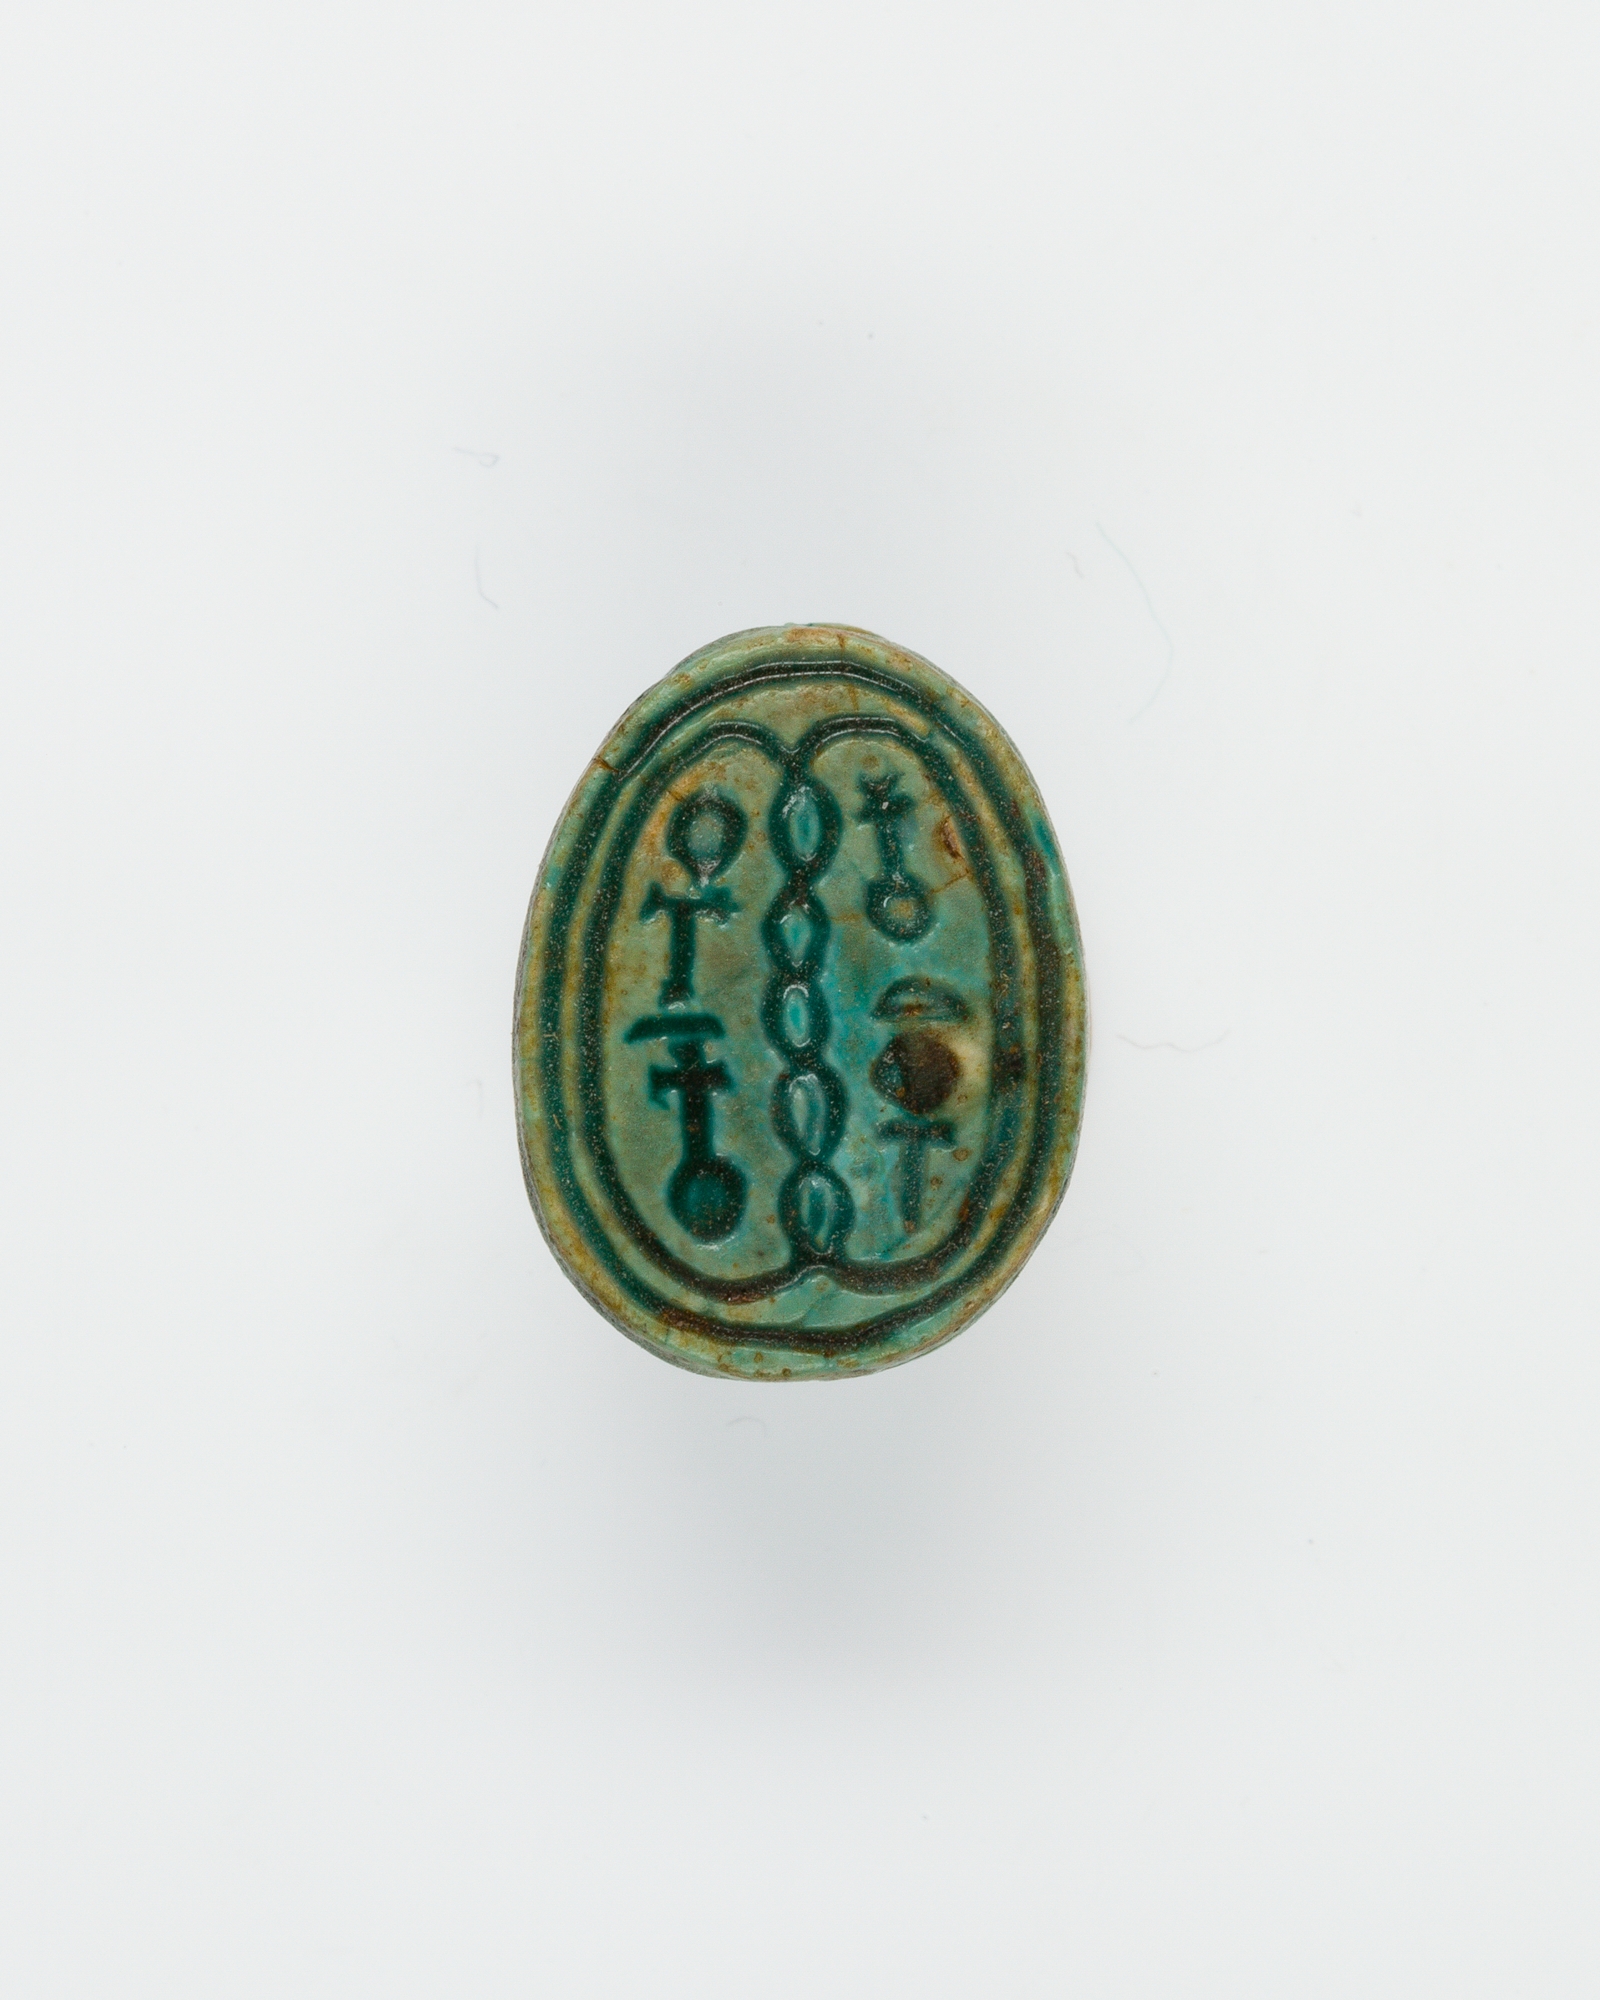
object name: scarab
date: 1492-1479 BCE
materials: stone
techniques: glazing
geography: egypt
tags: scarabs